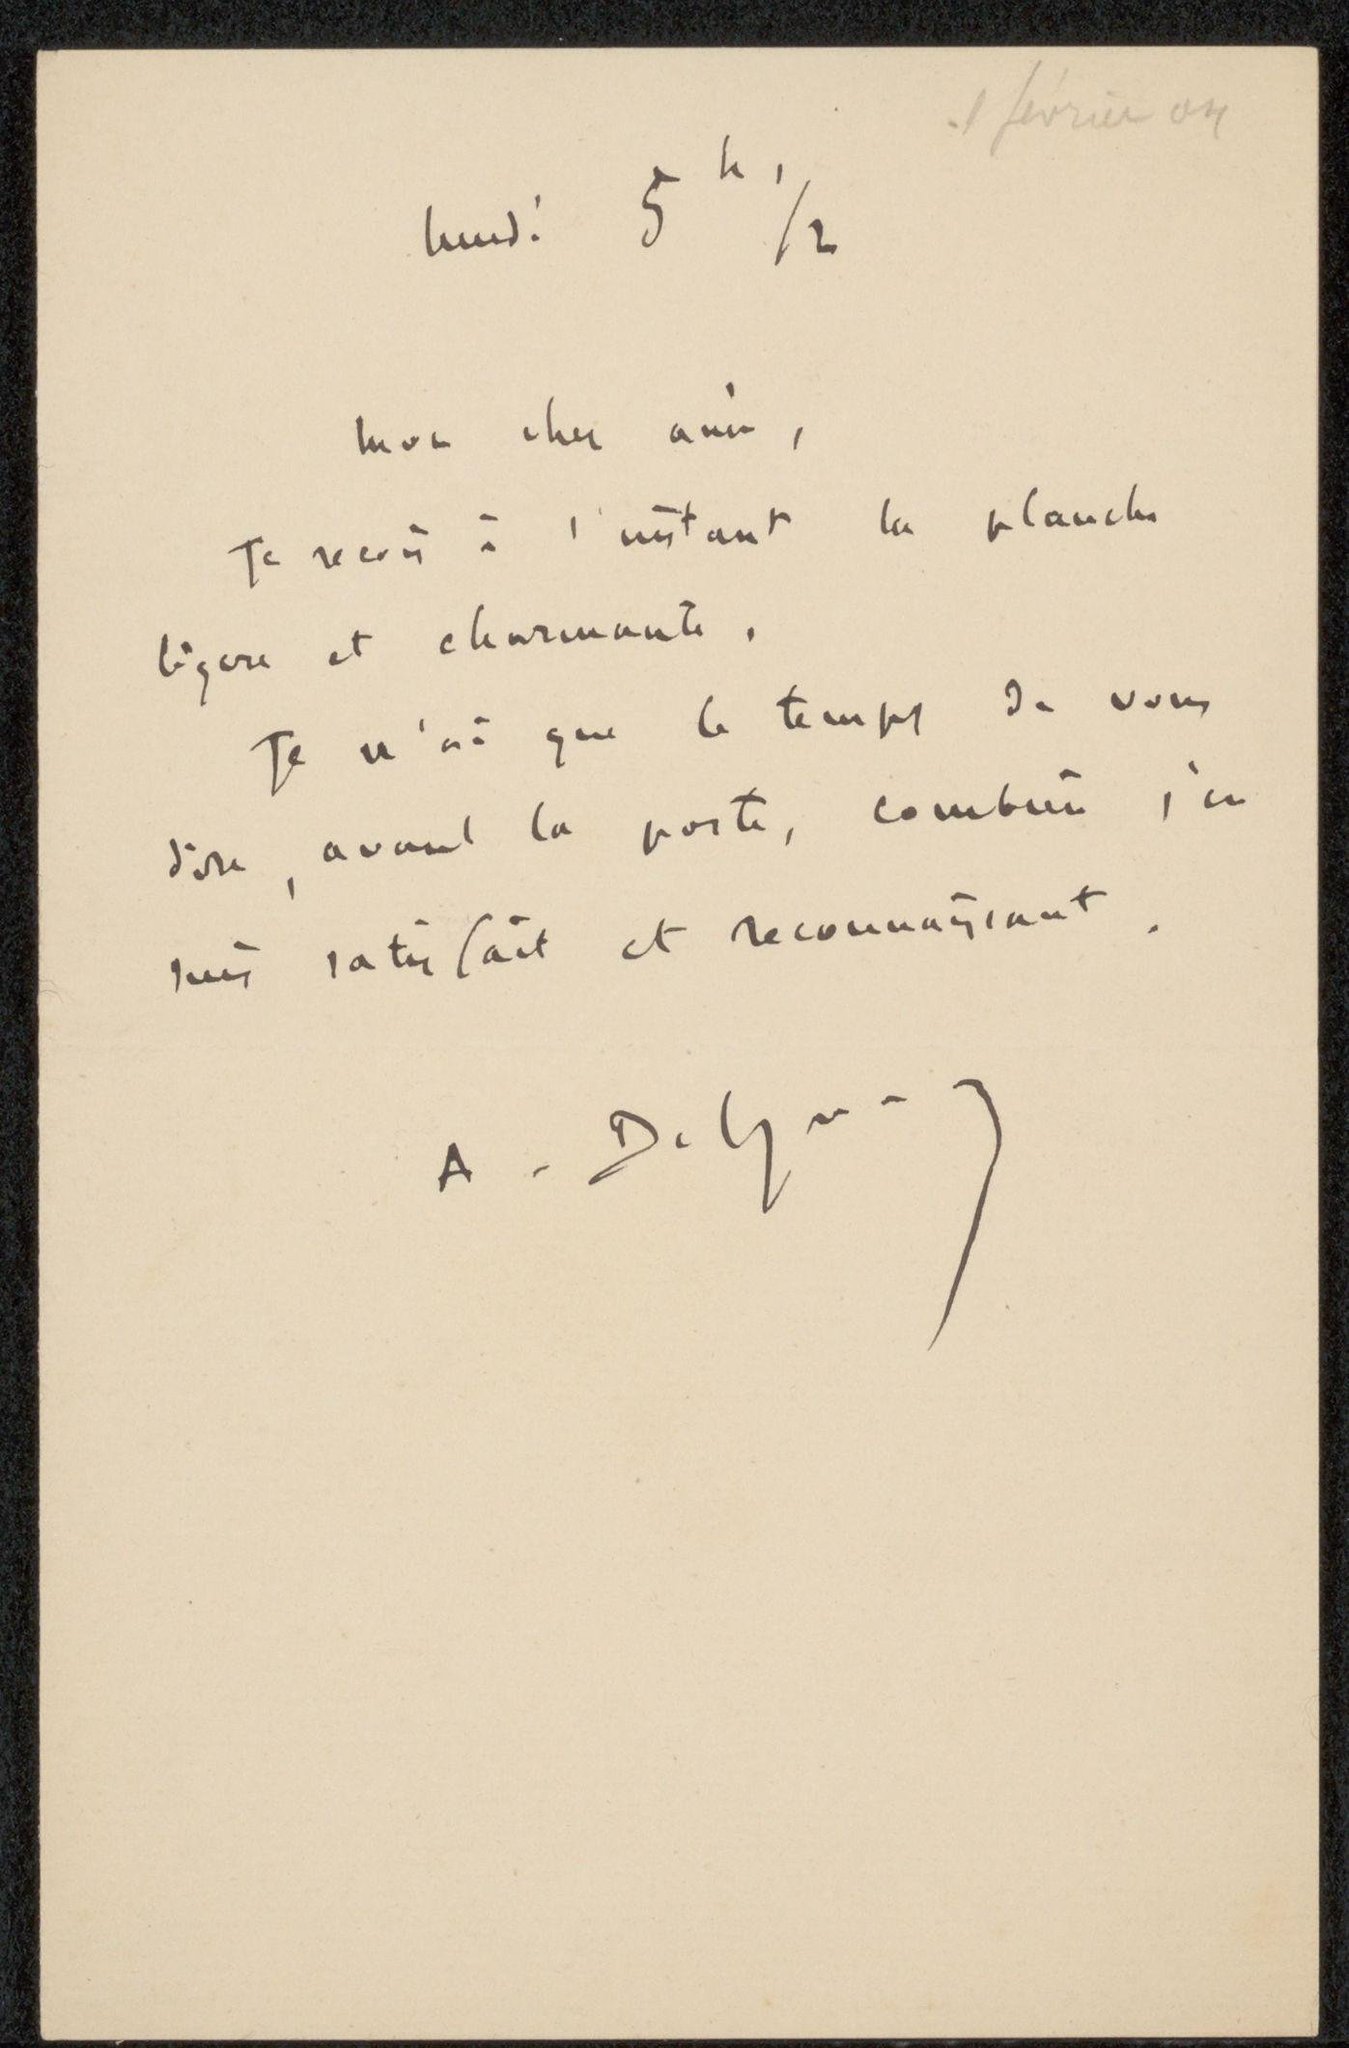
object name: letter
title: Brief aan Philip Zilcken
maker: alidor delzant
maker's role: advocaat, auteur, kunstverzamelaar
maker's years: 1848-1905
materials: ink, paper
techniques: pen, writing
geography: paris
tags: the hague, painter, draughtsman, philip zilcken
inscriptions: collector's mark: ‘RPK’